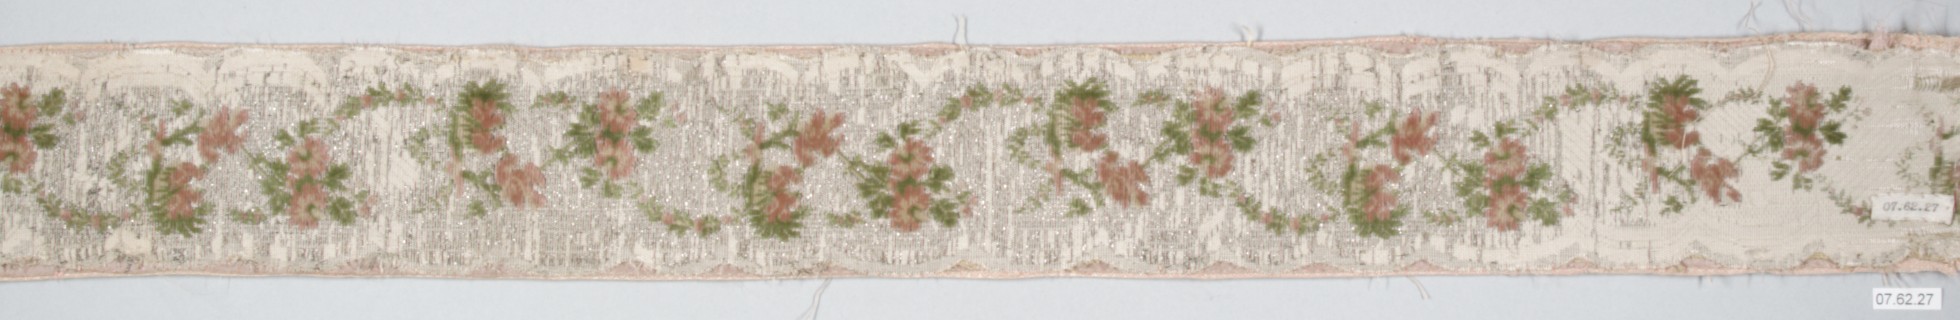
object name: ribbon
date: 1701-1800